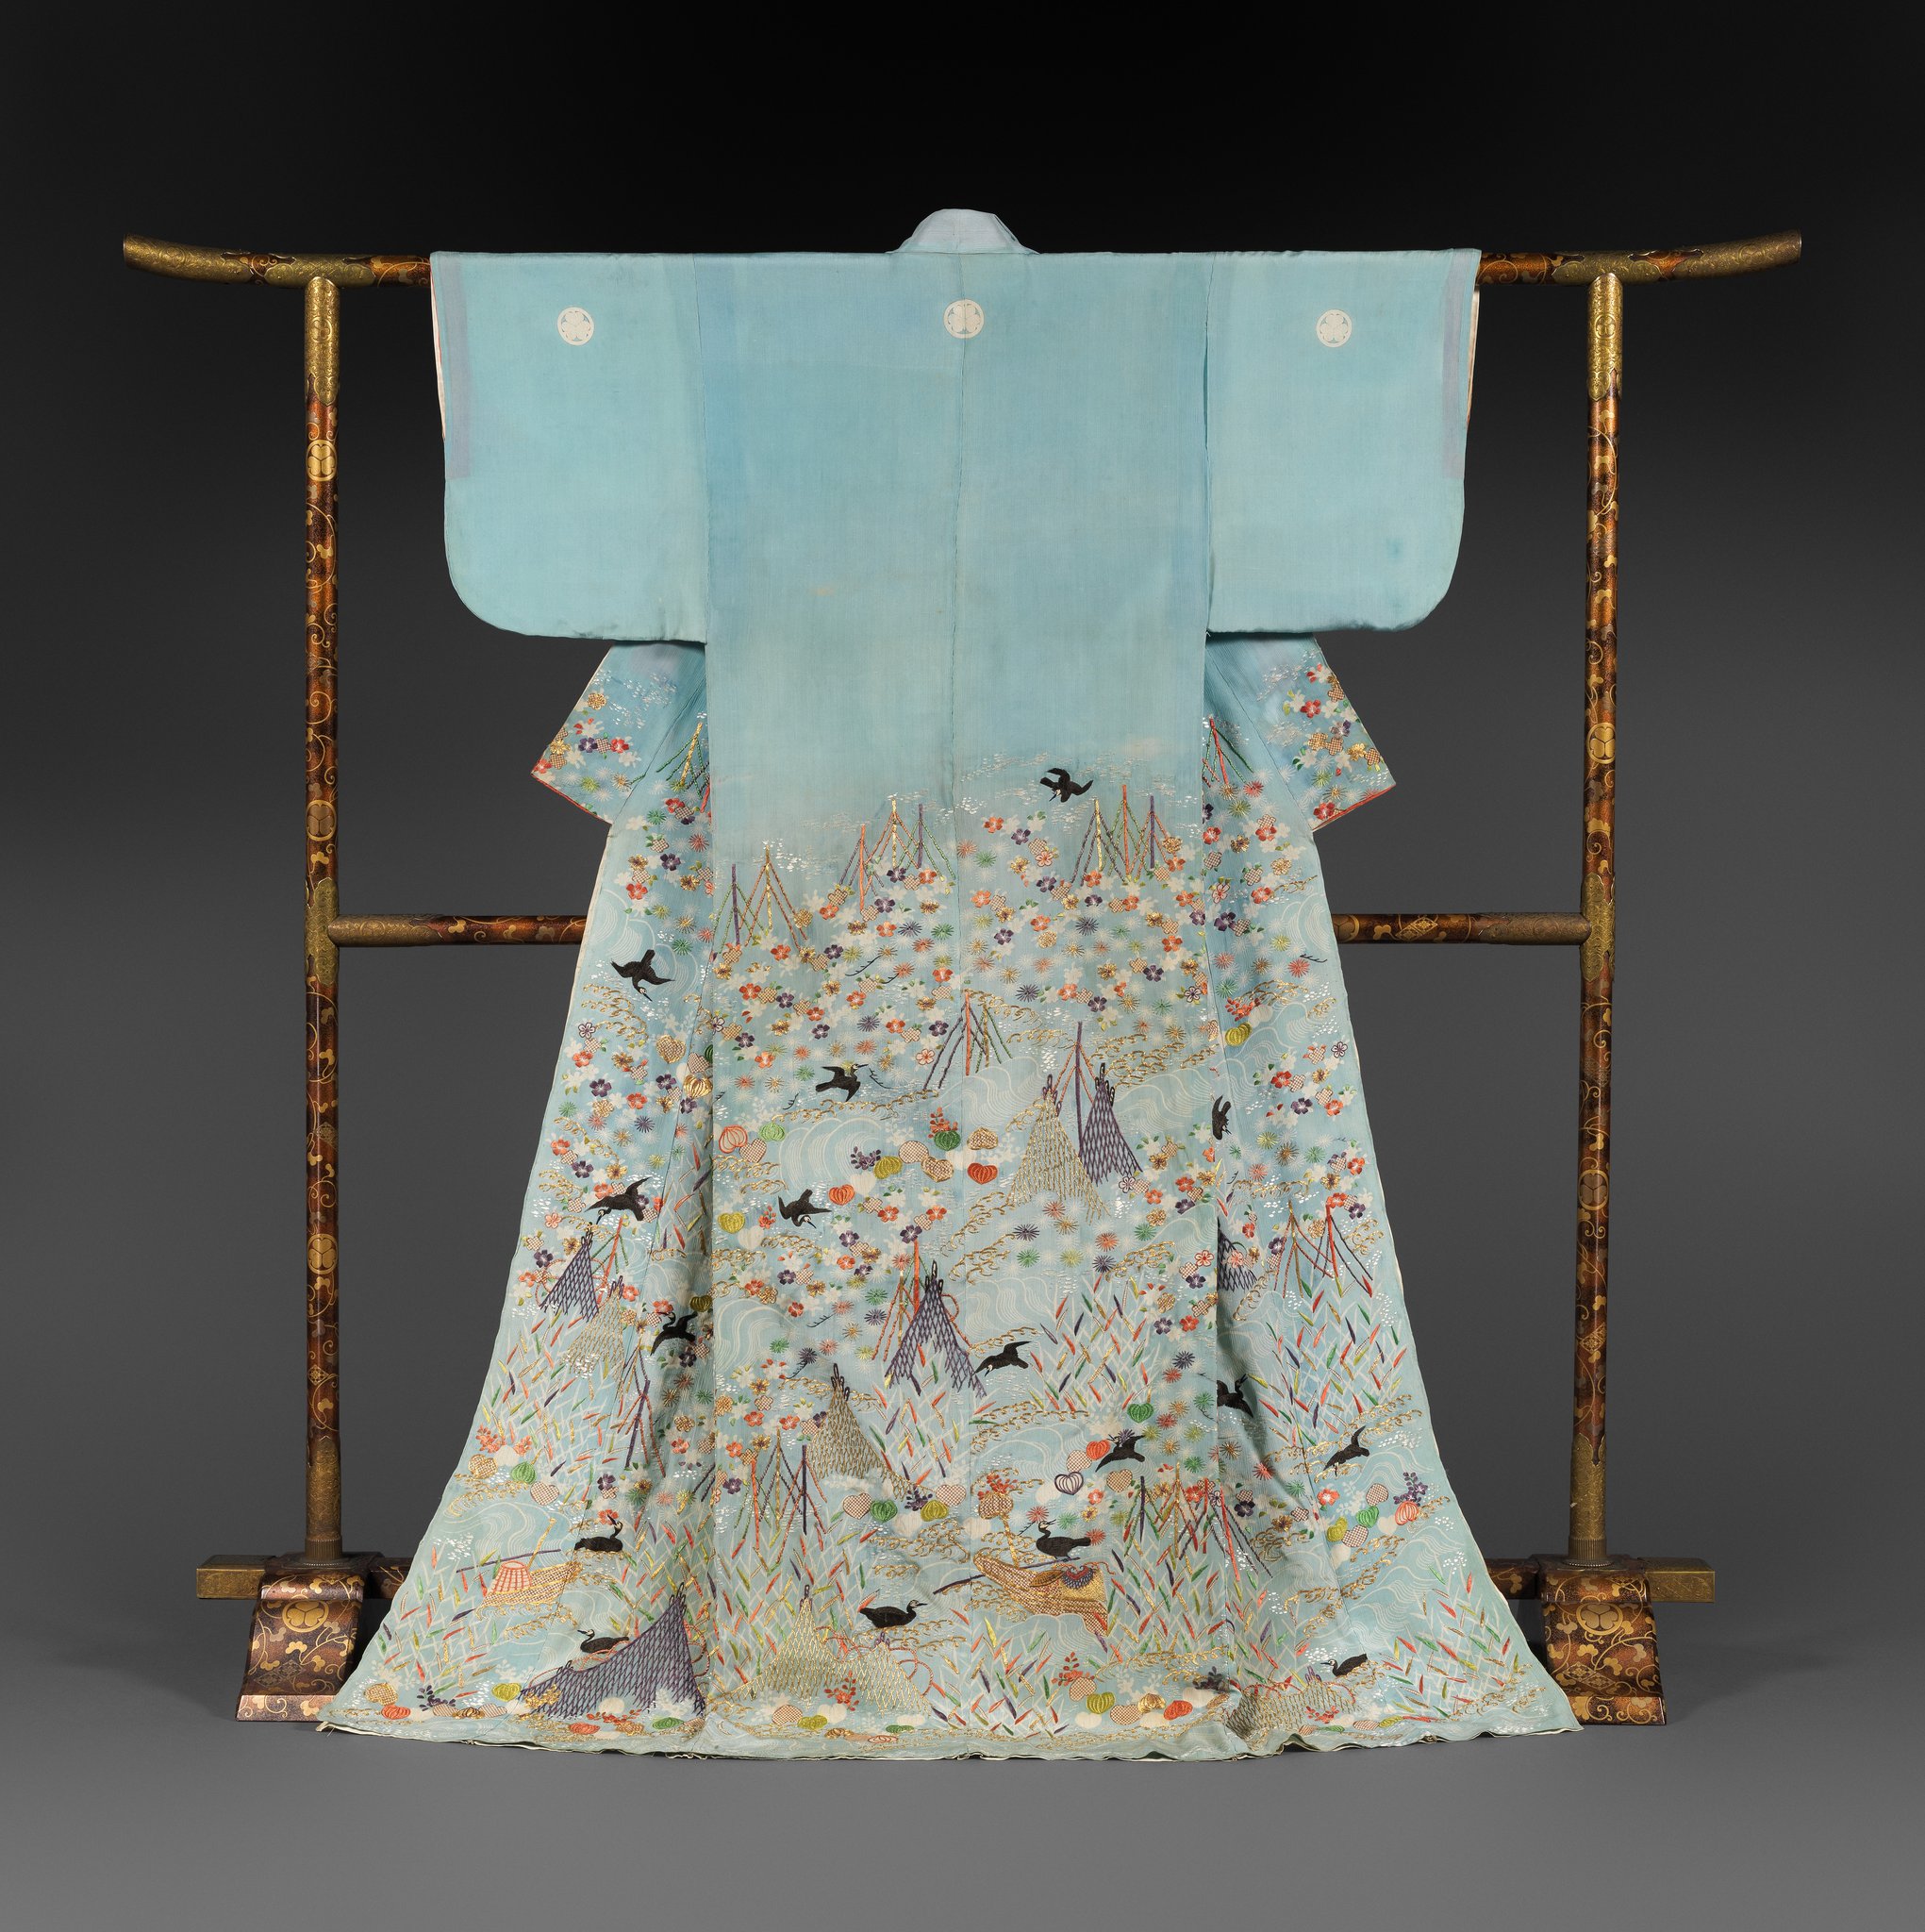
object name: robe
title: Summer Robe (Hito-e) with Cormorant-Fishing Scene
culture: japanese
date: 1767-1833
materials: gold thread, paste, silk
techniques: dyeing, embroidery, painting, resist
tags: birds